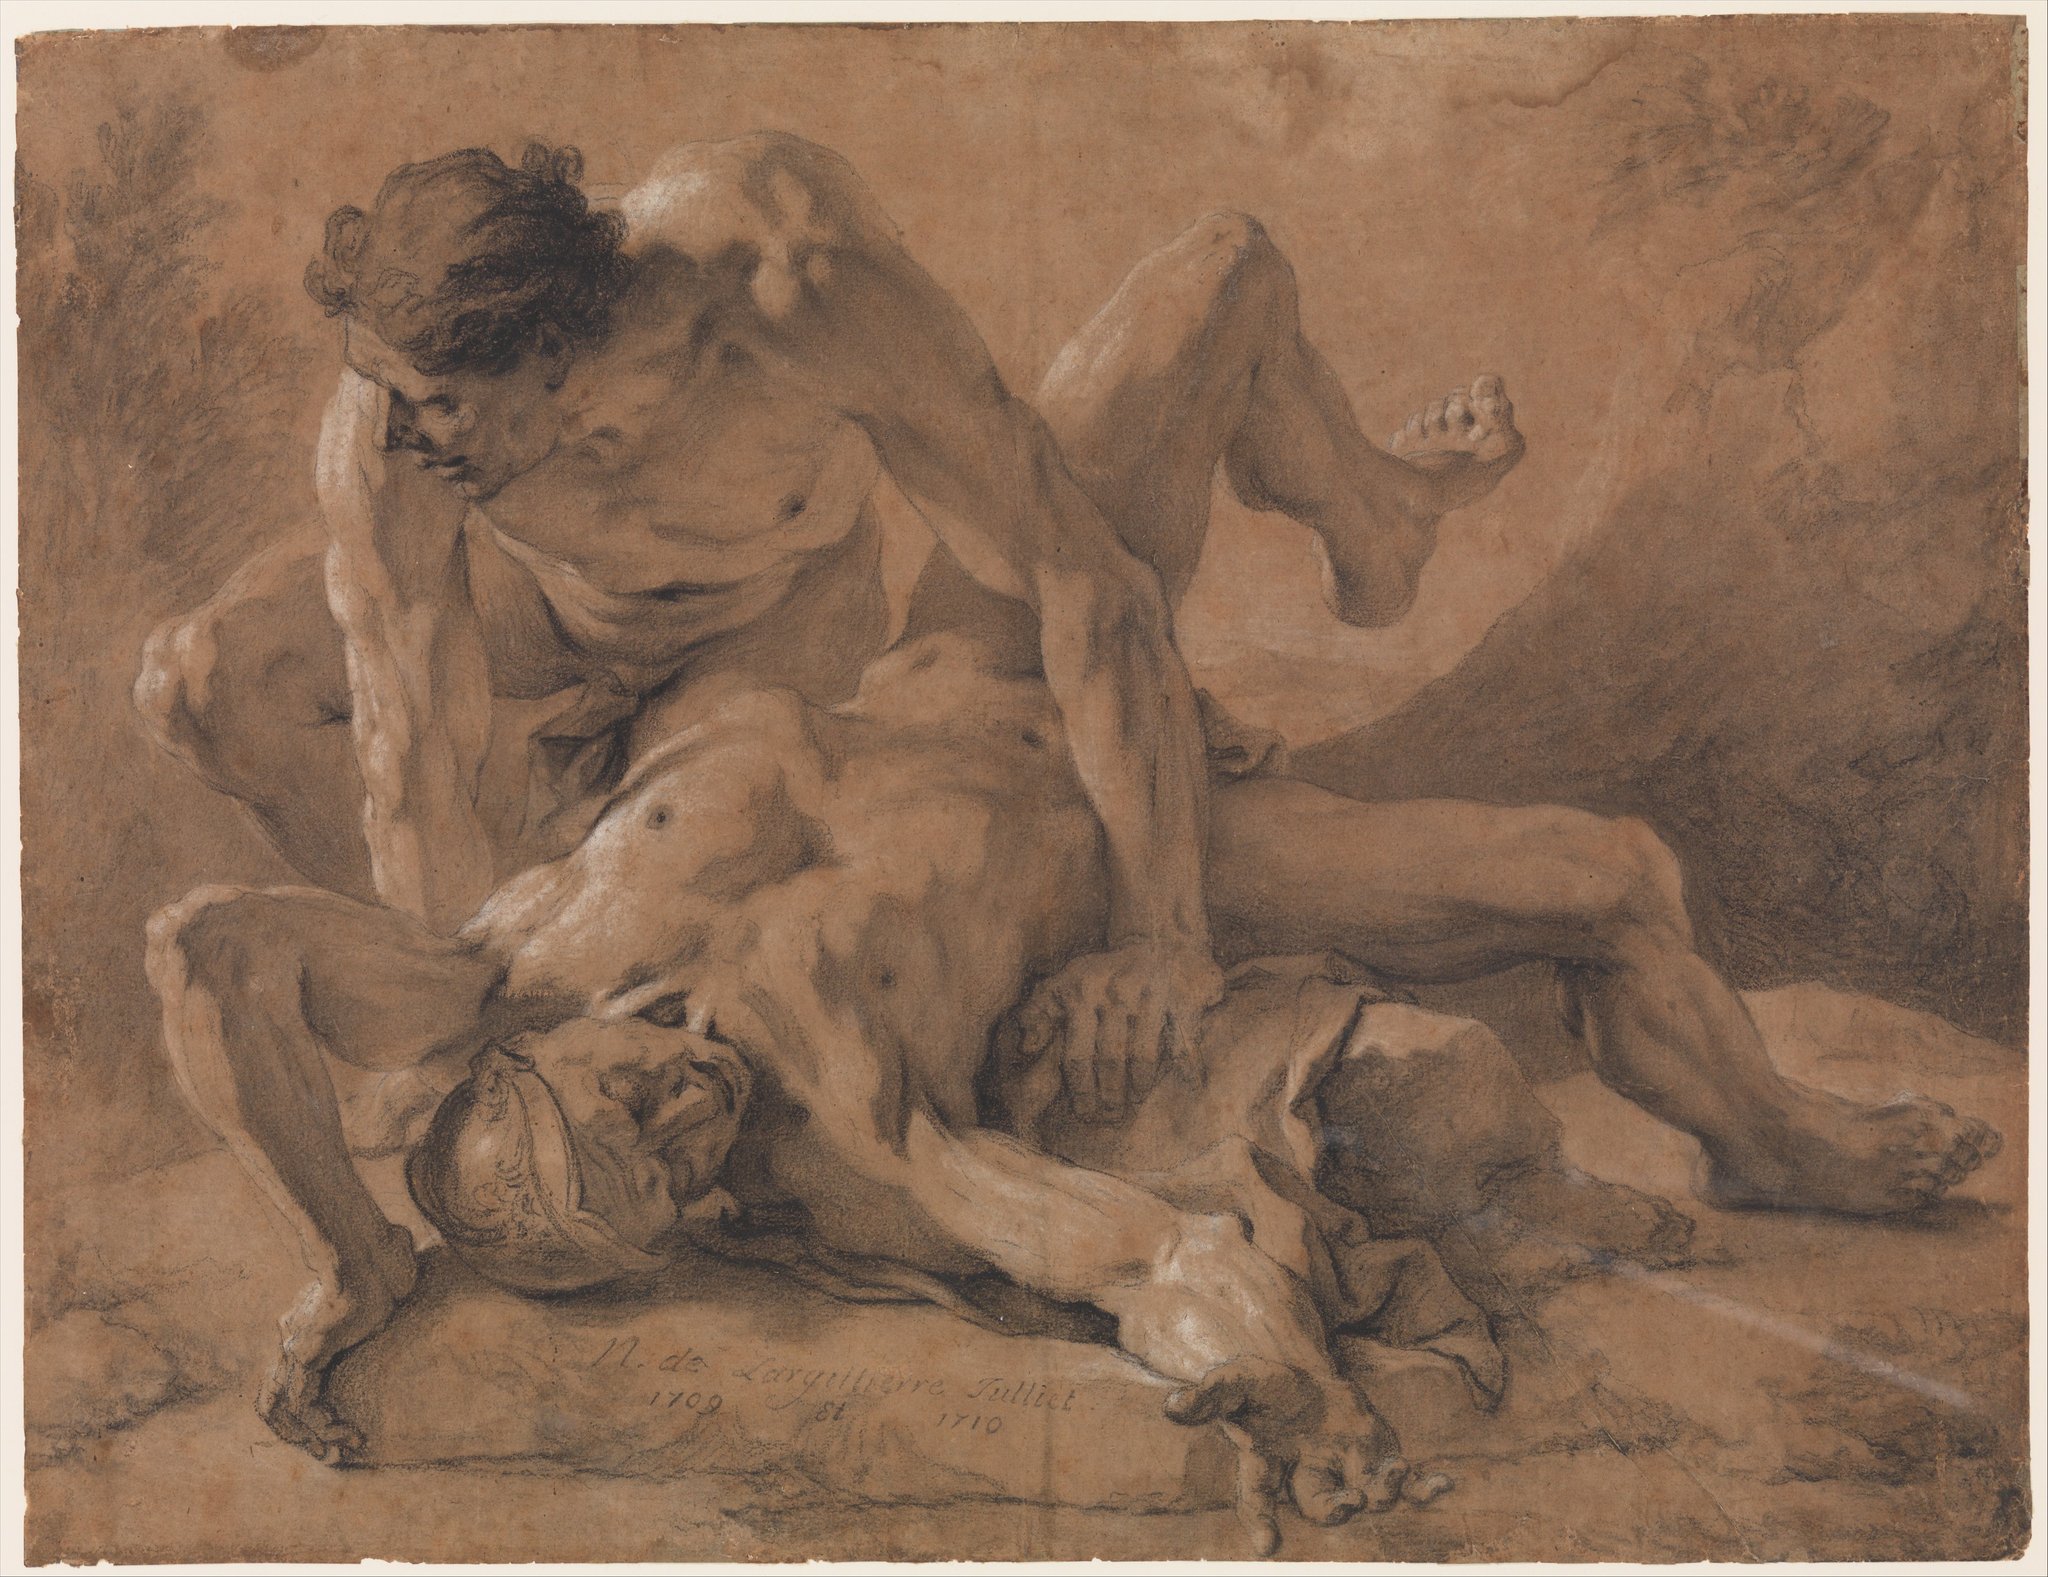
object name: drawing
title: Two Nude Male Figures Struggling Together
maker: nicolas de largillierre (or largillière)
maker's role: artist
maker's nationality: french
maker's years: 1656-1746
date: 1709-1710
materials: chalk, charcoal, paper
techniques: stumping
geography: france